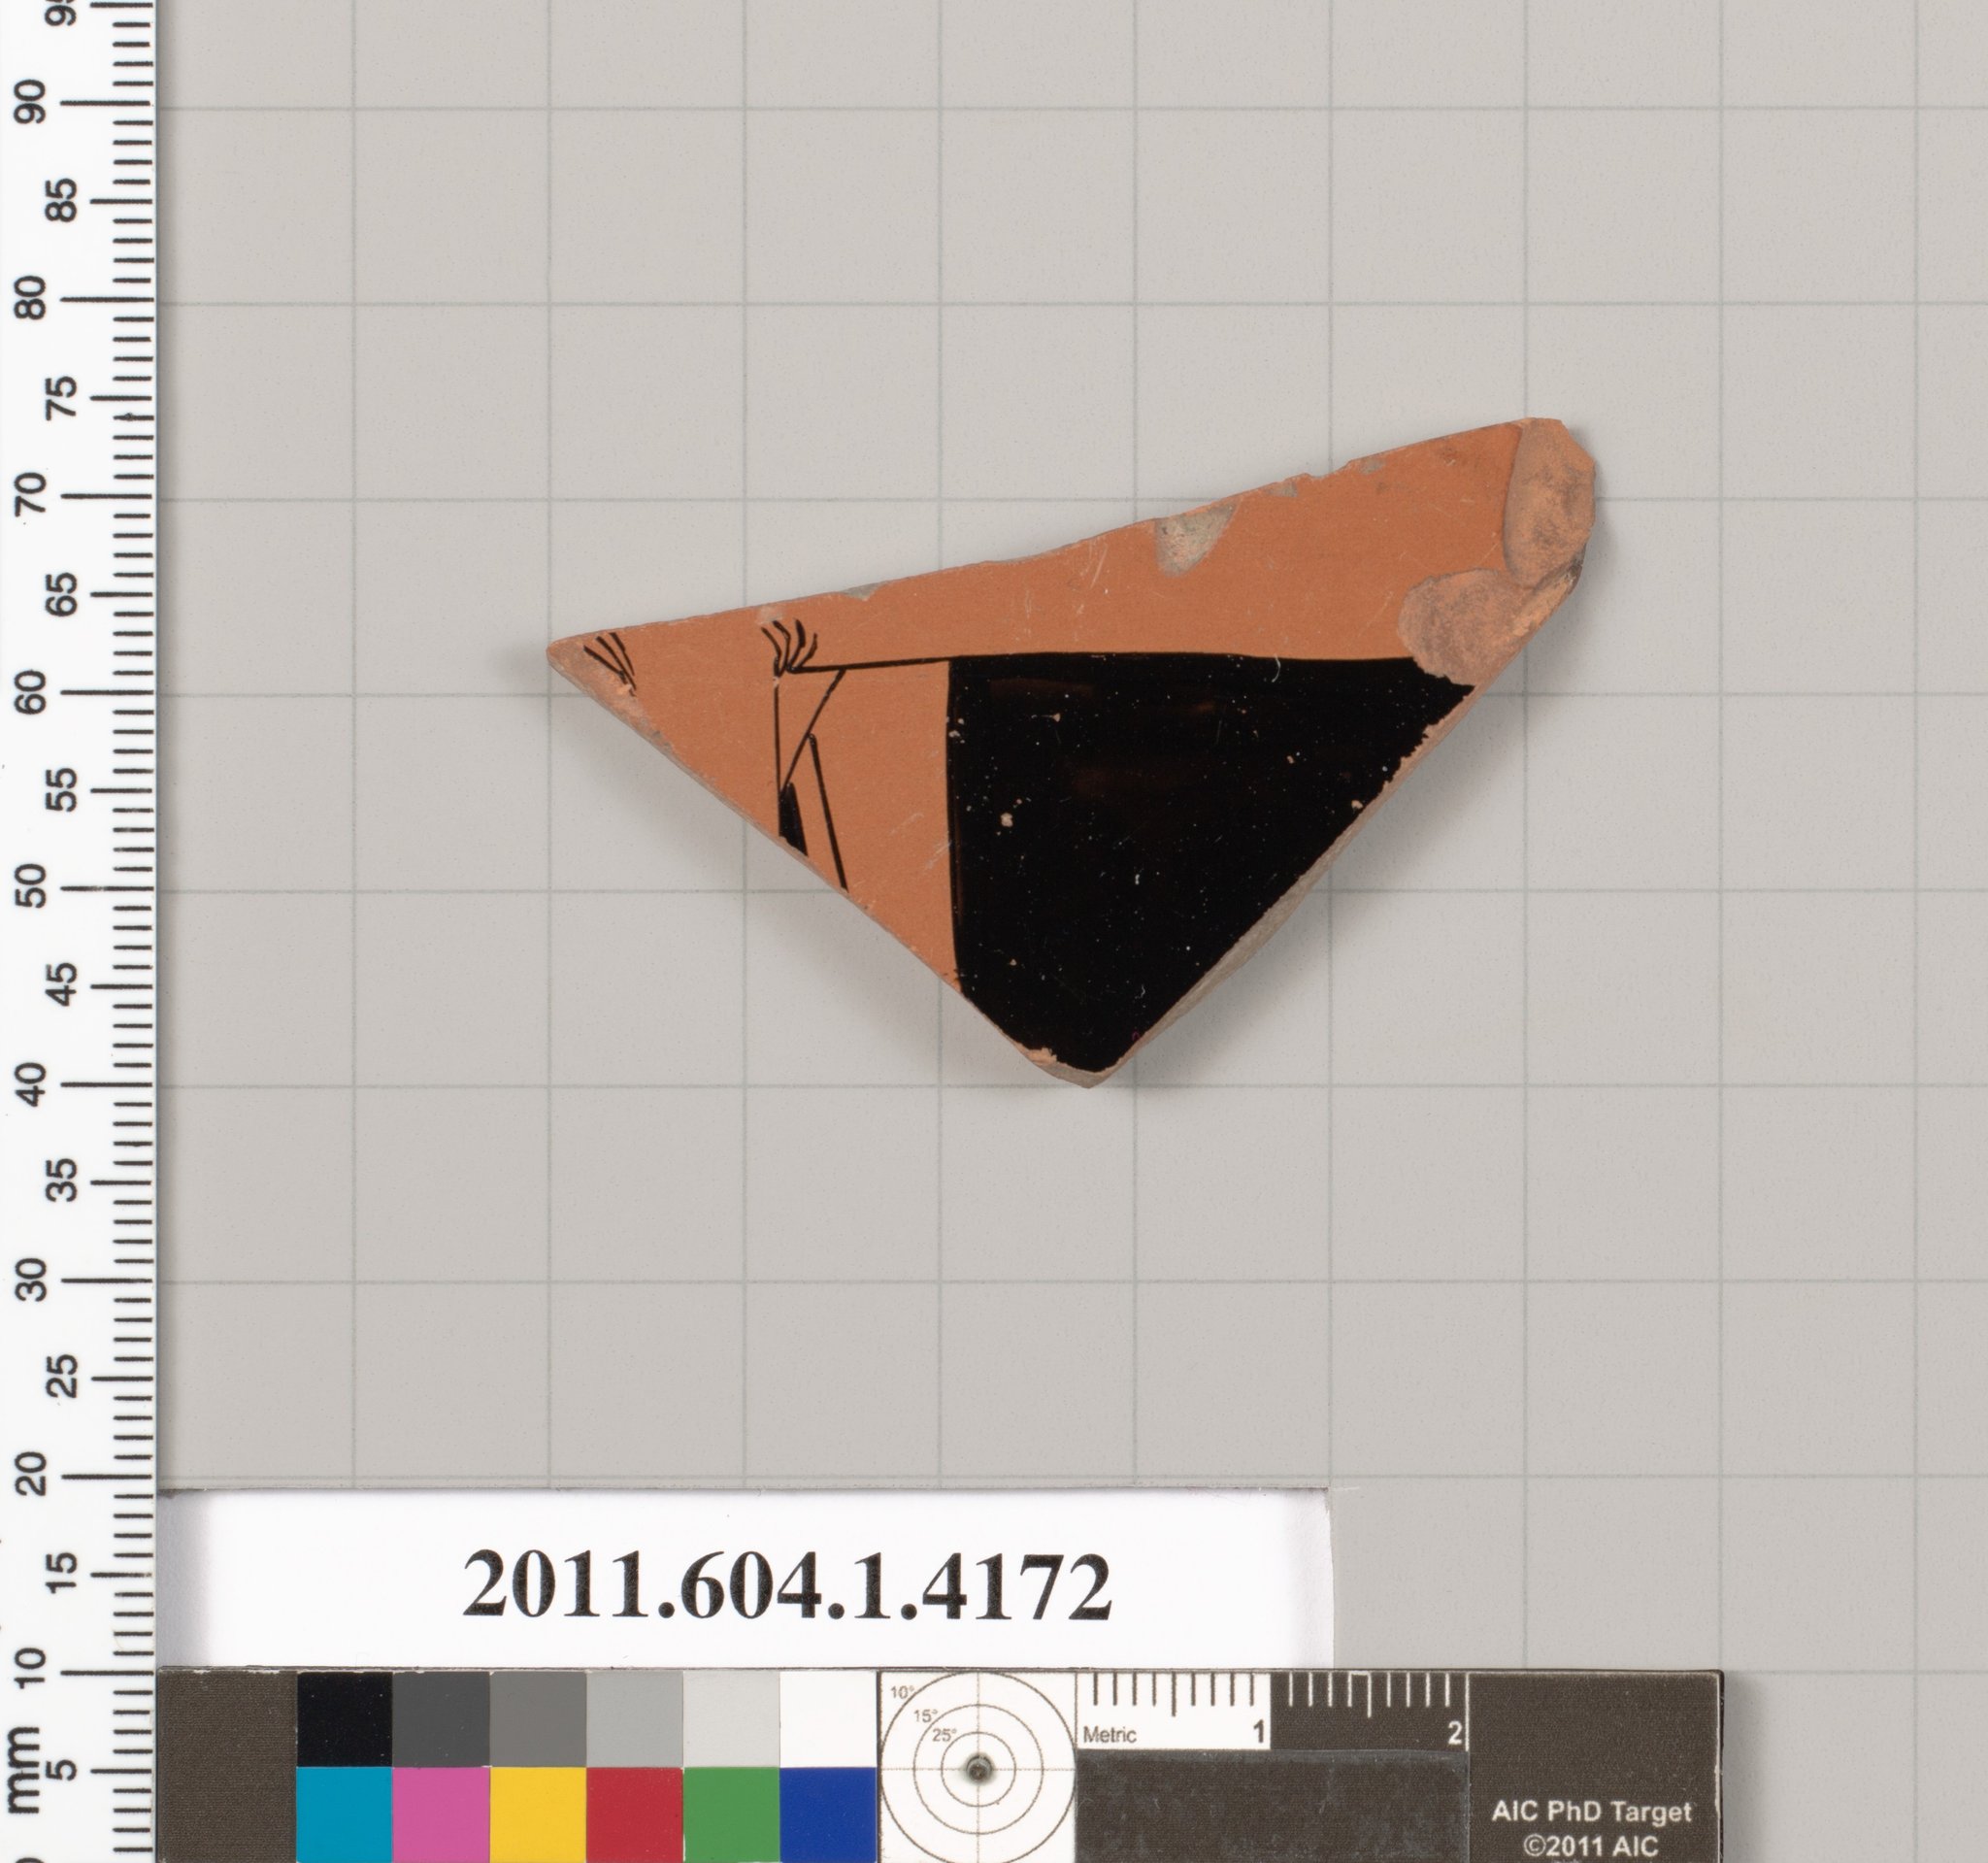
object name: kylix fragment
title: Terracotta fragment of a kylix (drinking cup)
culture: greek, attic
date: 500-480 BCE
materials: terracotta